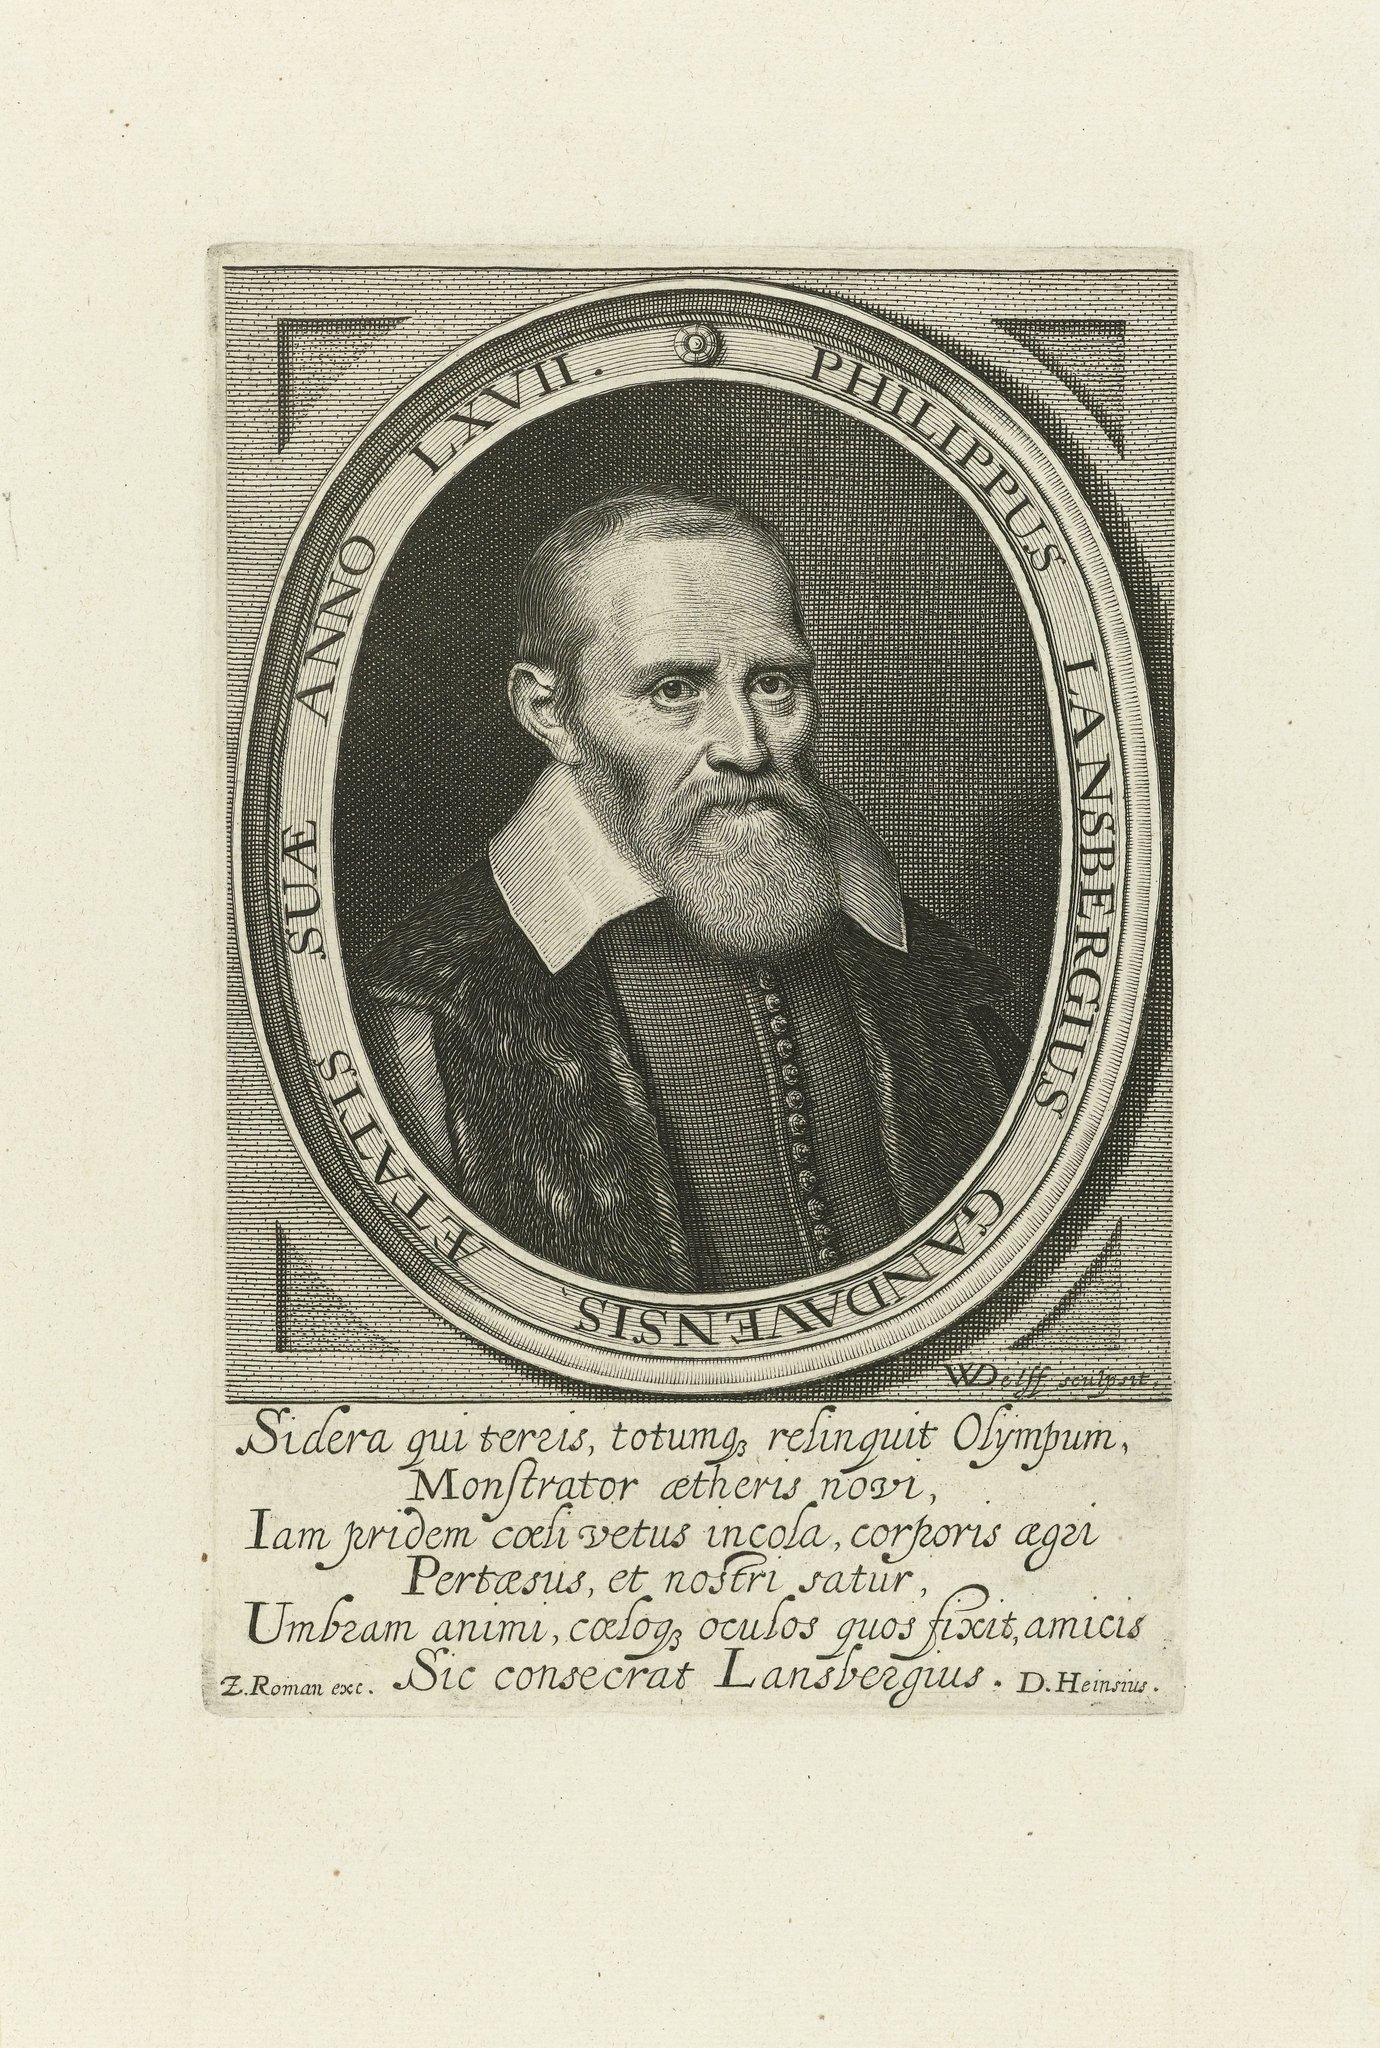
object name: print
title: Portret van Johan Philip Lansberge op 67-jarige leeftijd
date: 1628-1638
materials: paper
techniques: engraving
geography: delft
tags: ghent, middelburg, physicist, philippus lansbergen, portrait of a writer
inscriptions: collector's mark: Lugt 240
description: Portret van schrijver en astronoom Johan Philip Lansberge op 67-jarige leeftijd, borststuk gekleed in toga in ovale omlijsting. Latijns vers van zes regels in ondermarge.